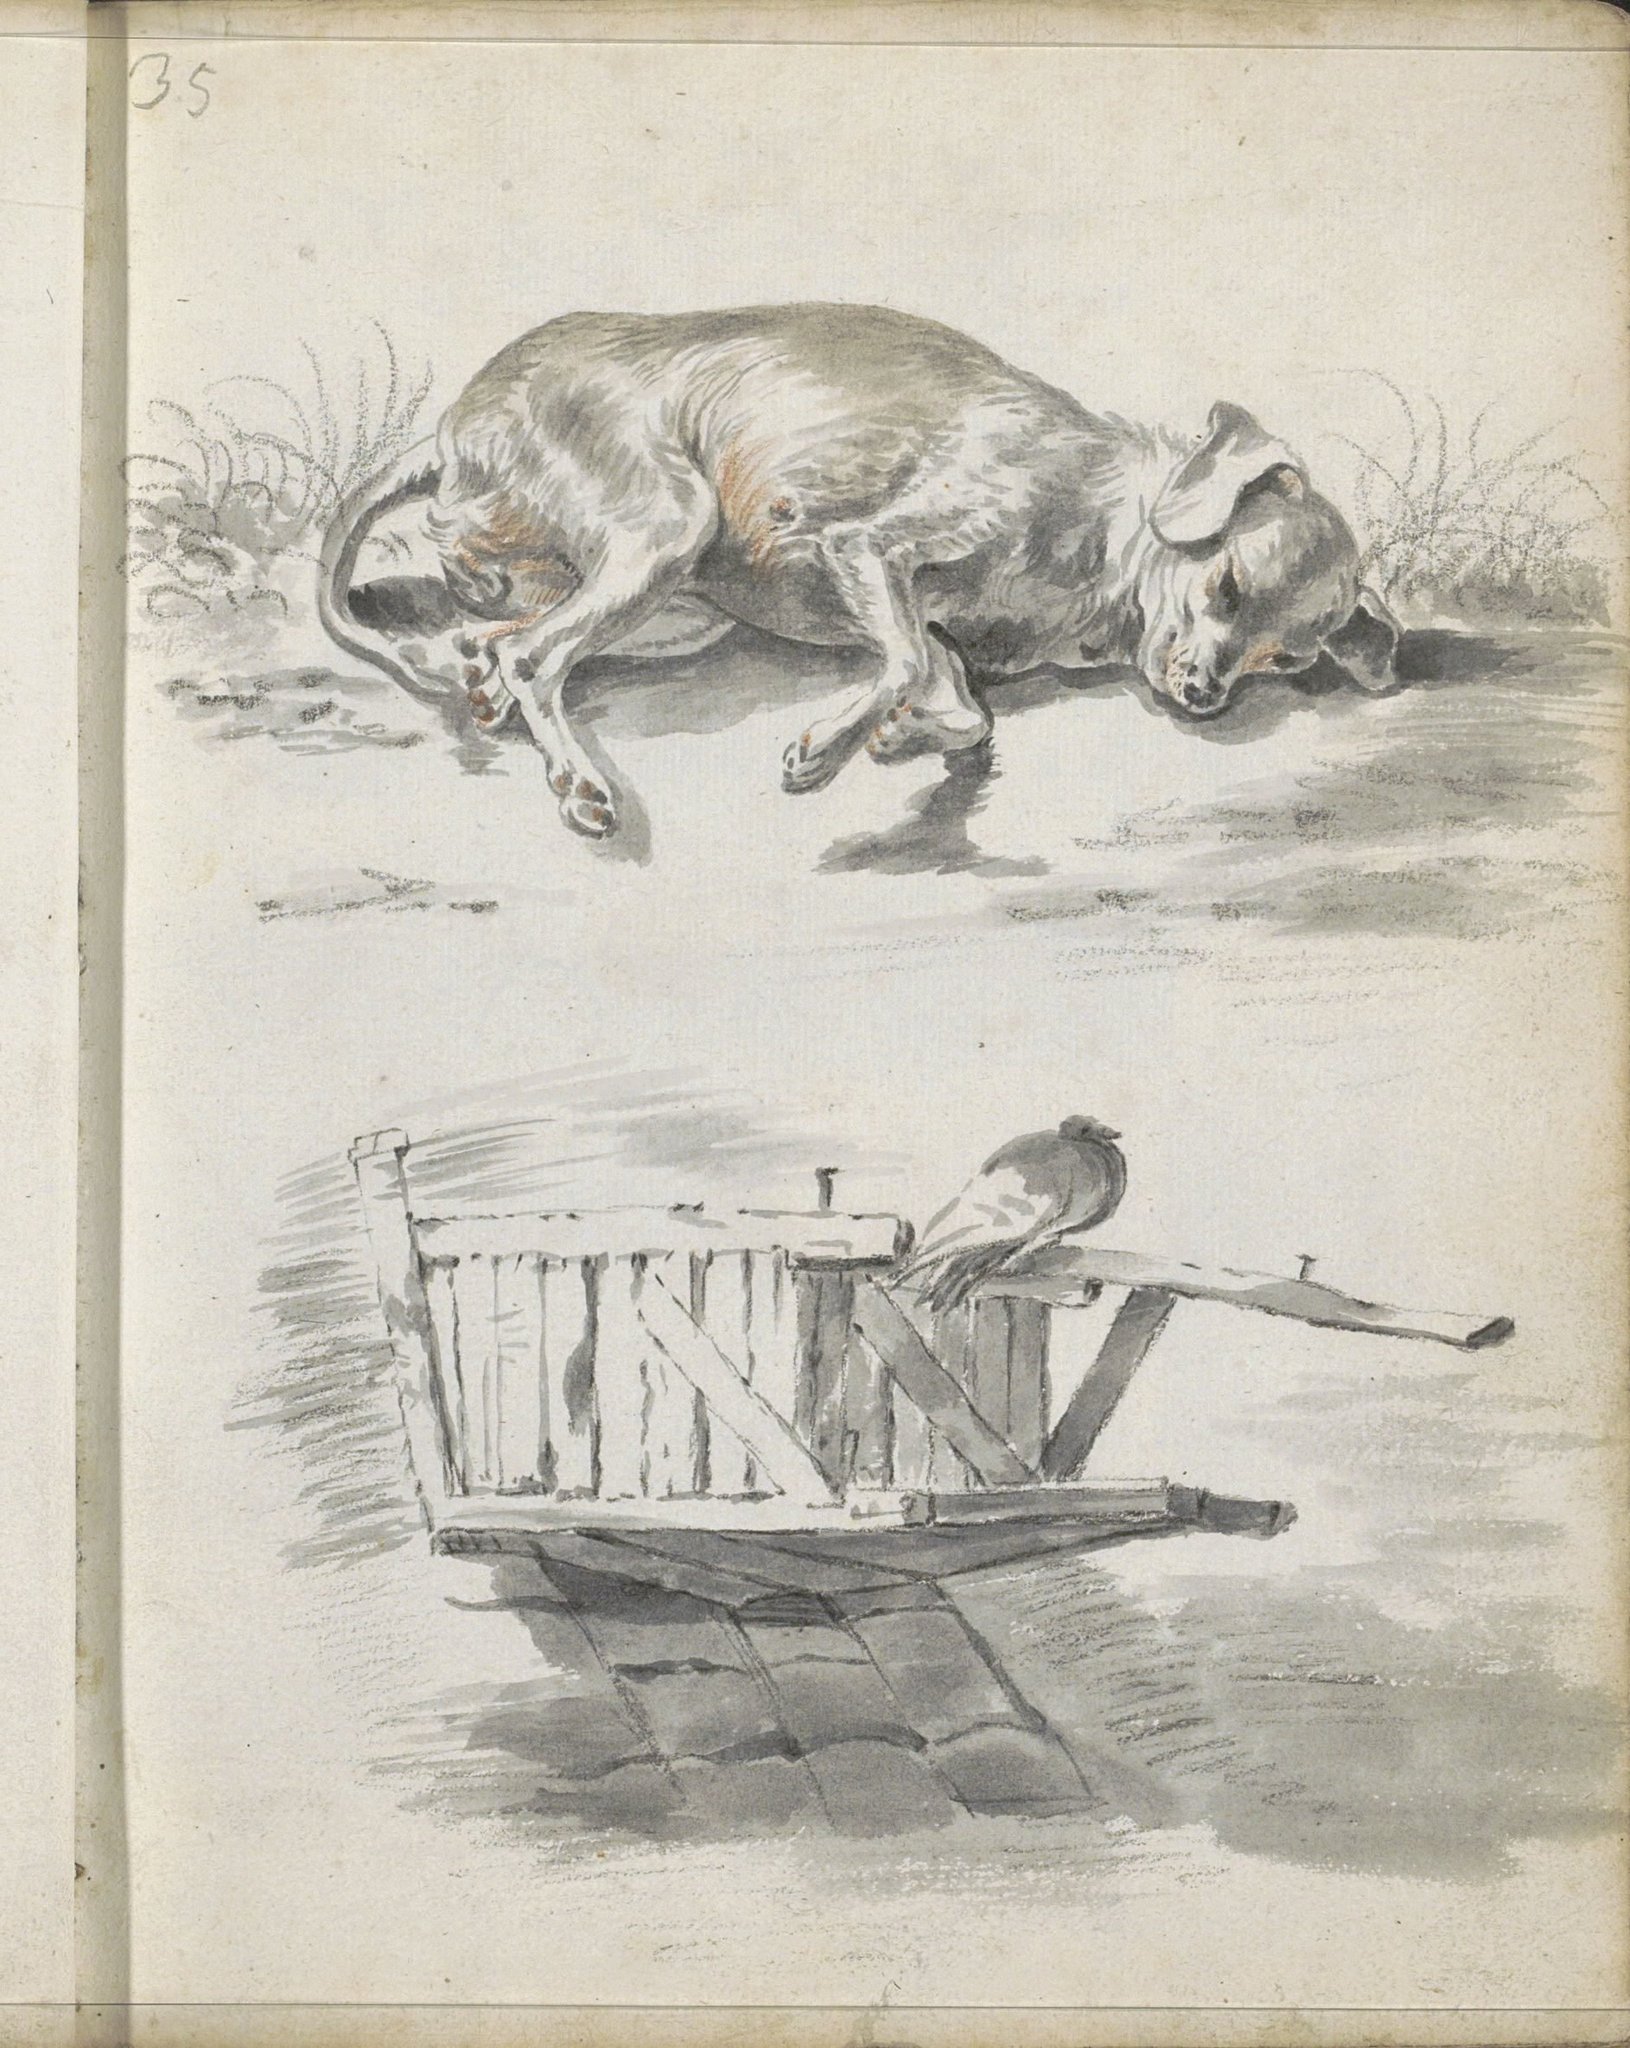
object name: sketchbook leaf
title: Liggende hond en een duif op een duiventil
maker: cornelis saftleven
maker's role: draughtsman, painter, print maker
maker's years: 1607-1681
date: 1666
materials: chalk, ink, paper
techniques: brush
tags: dove-cote, dog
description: Blad 35 recto uit een schetsboek met 49 bladen.